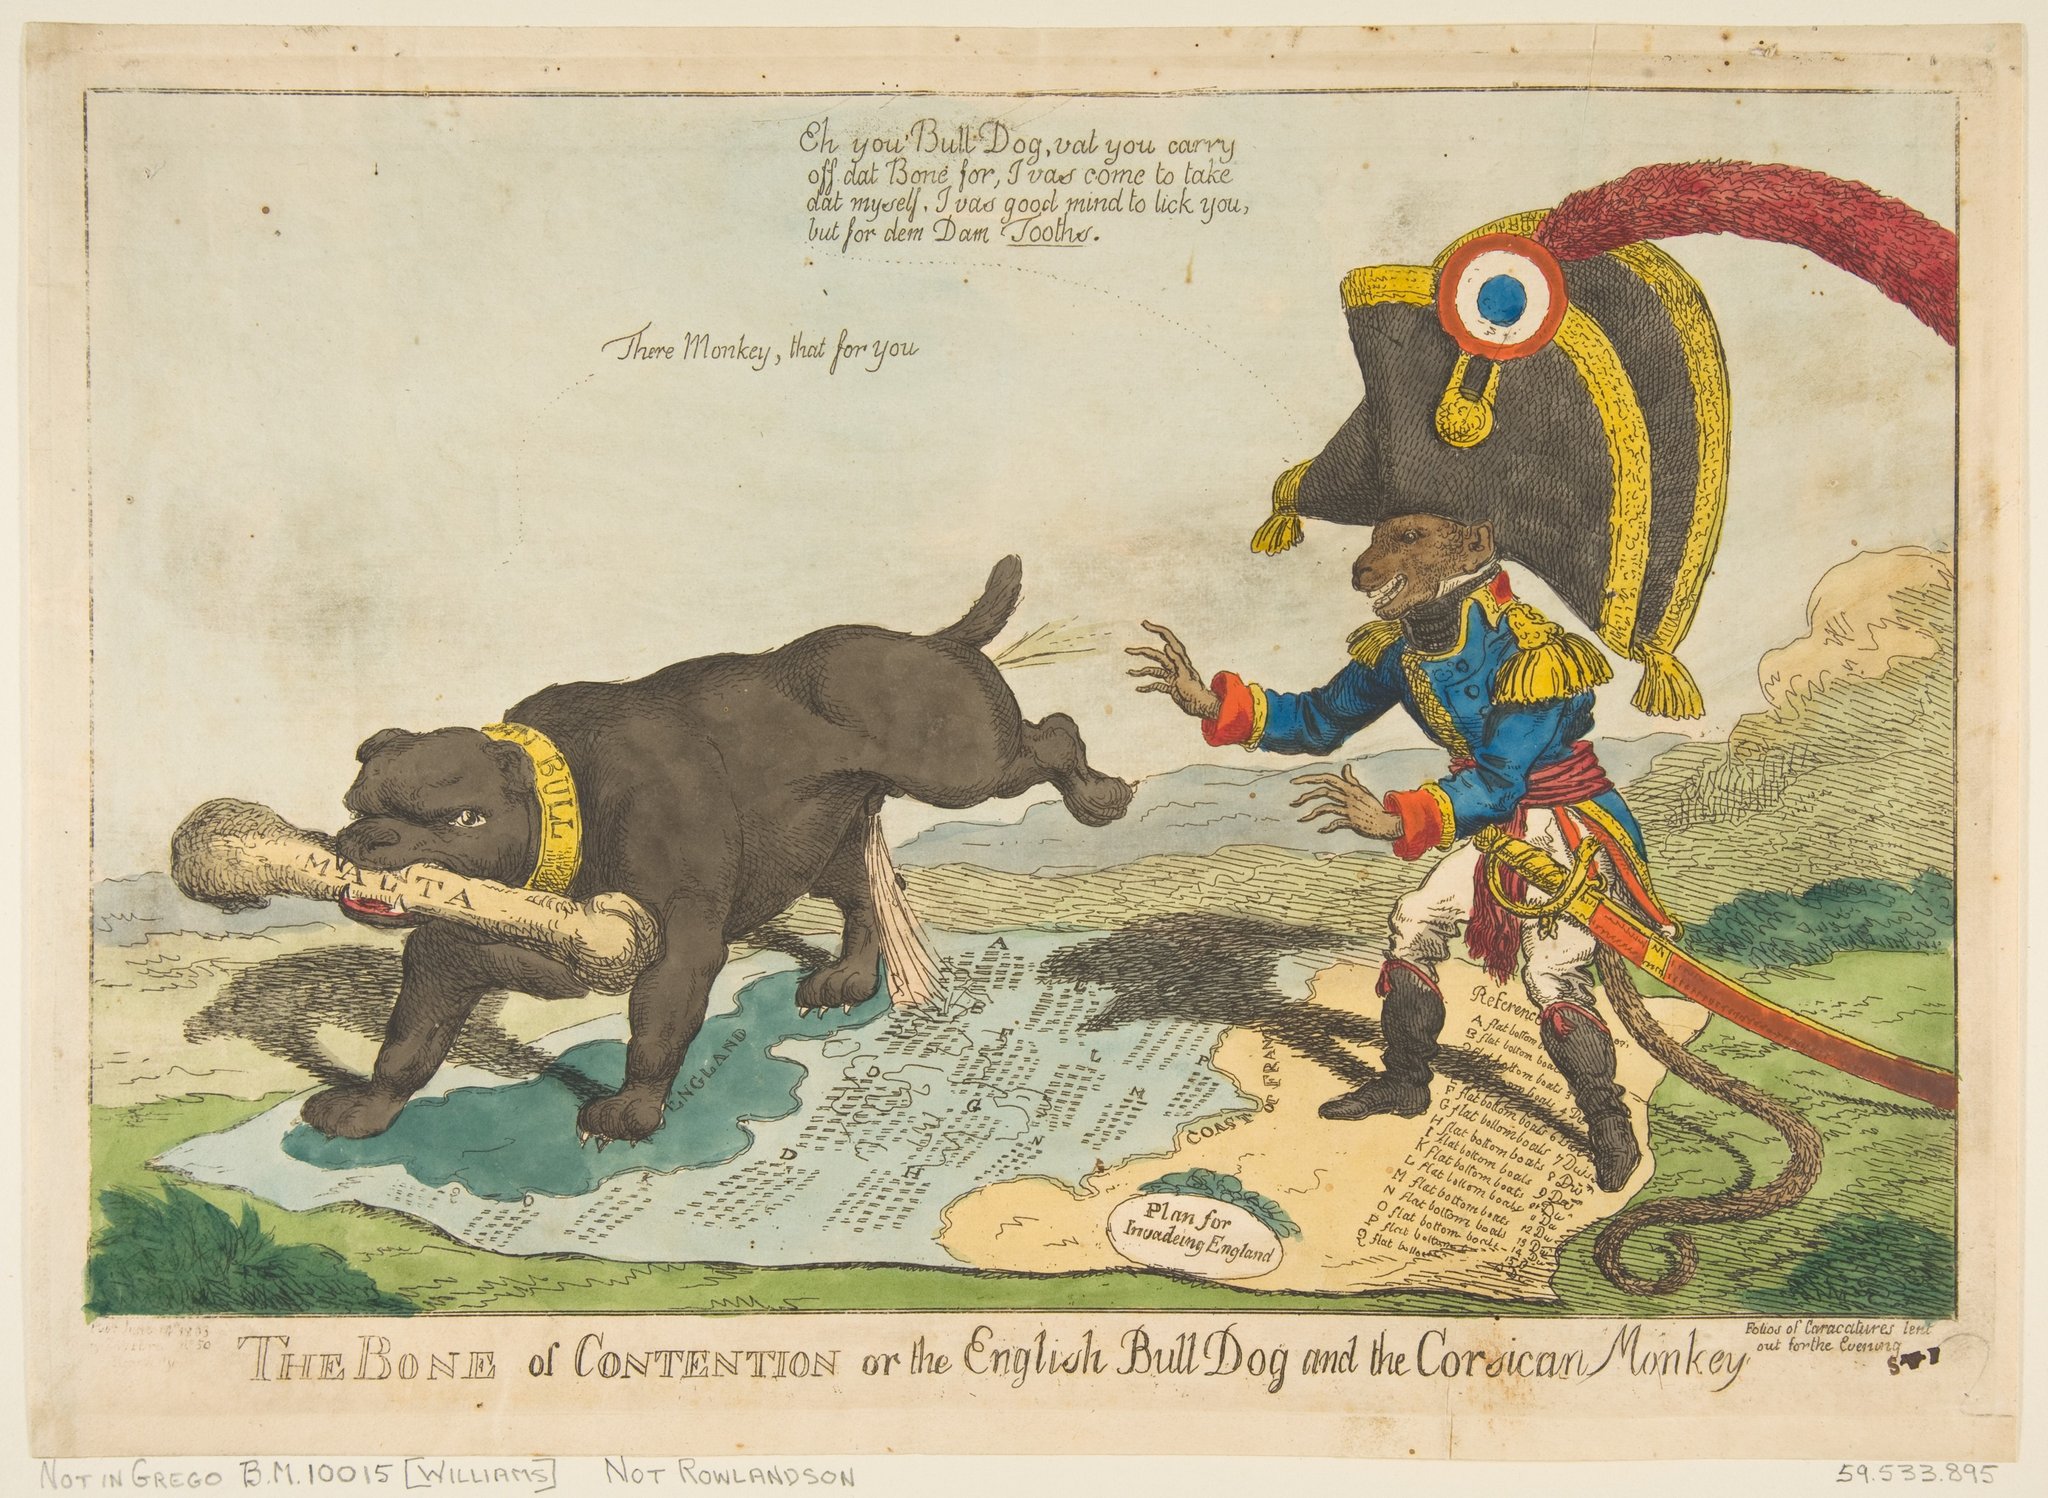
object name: print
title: The Bone of Contention or the English Bull Dog and the Corsican Monkey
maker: charles williams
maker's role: artist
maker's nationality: british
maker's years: 1750-1850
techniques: etching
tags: satire,napoleon i,dogs,monkeys,politics